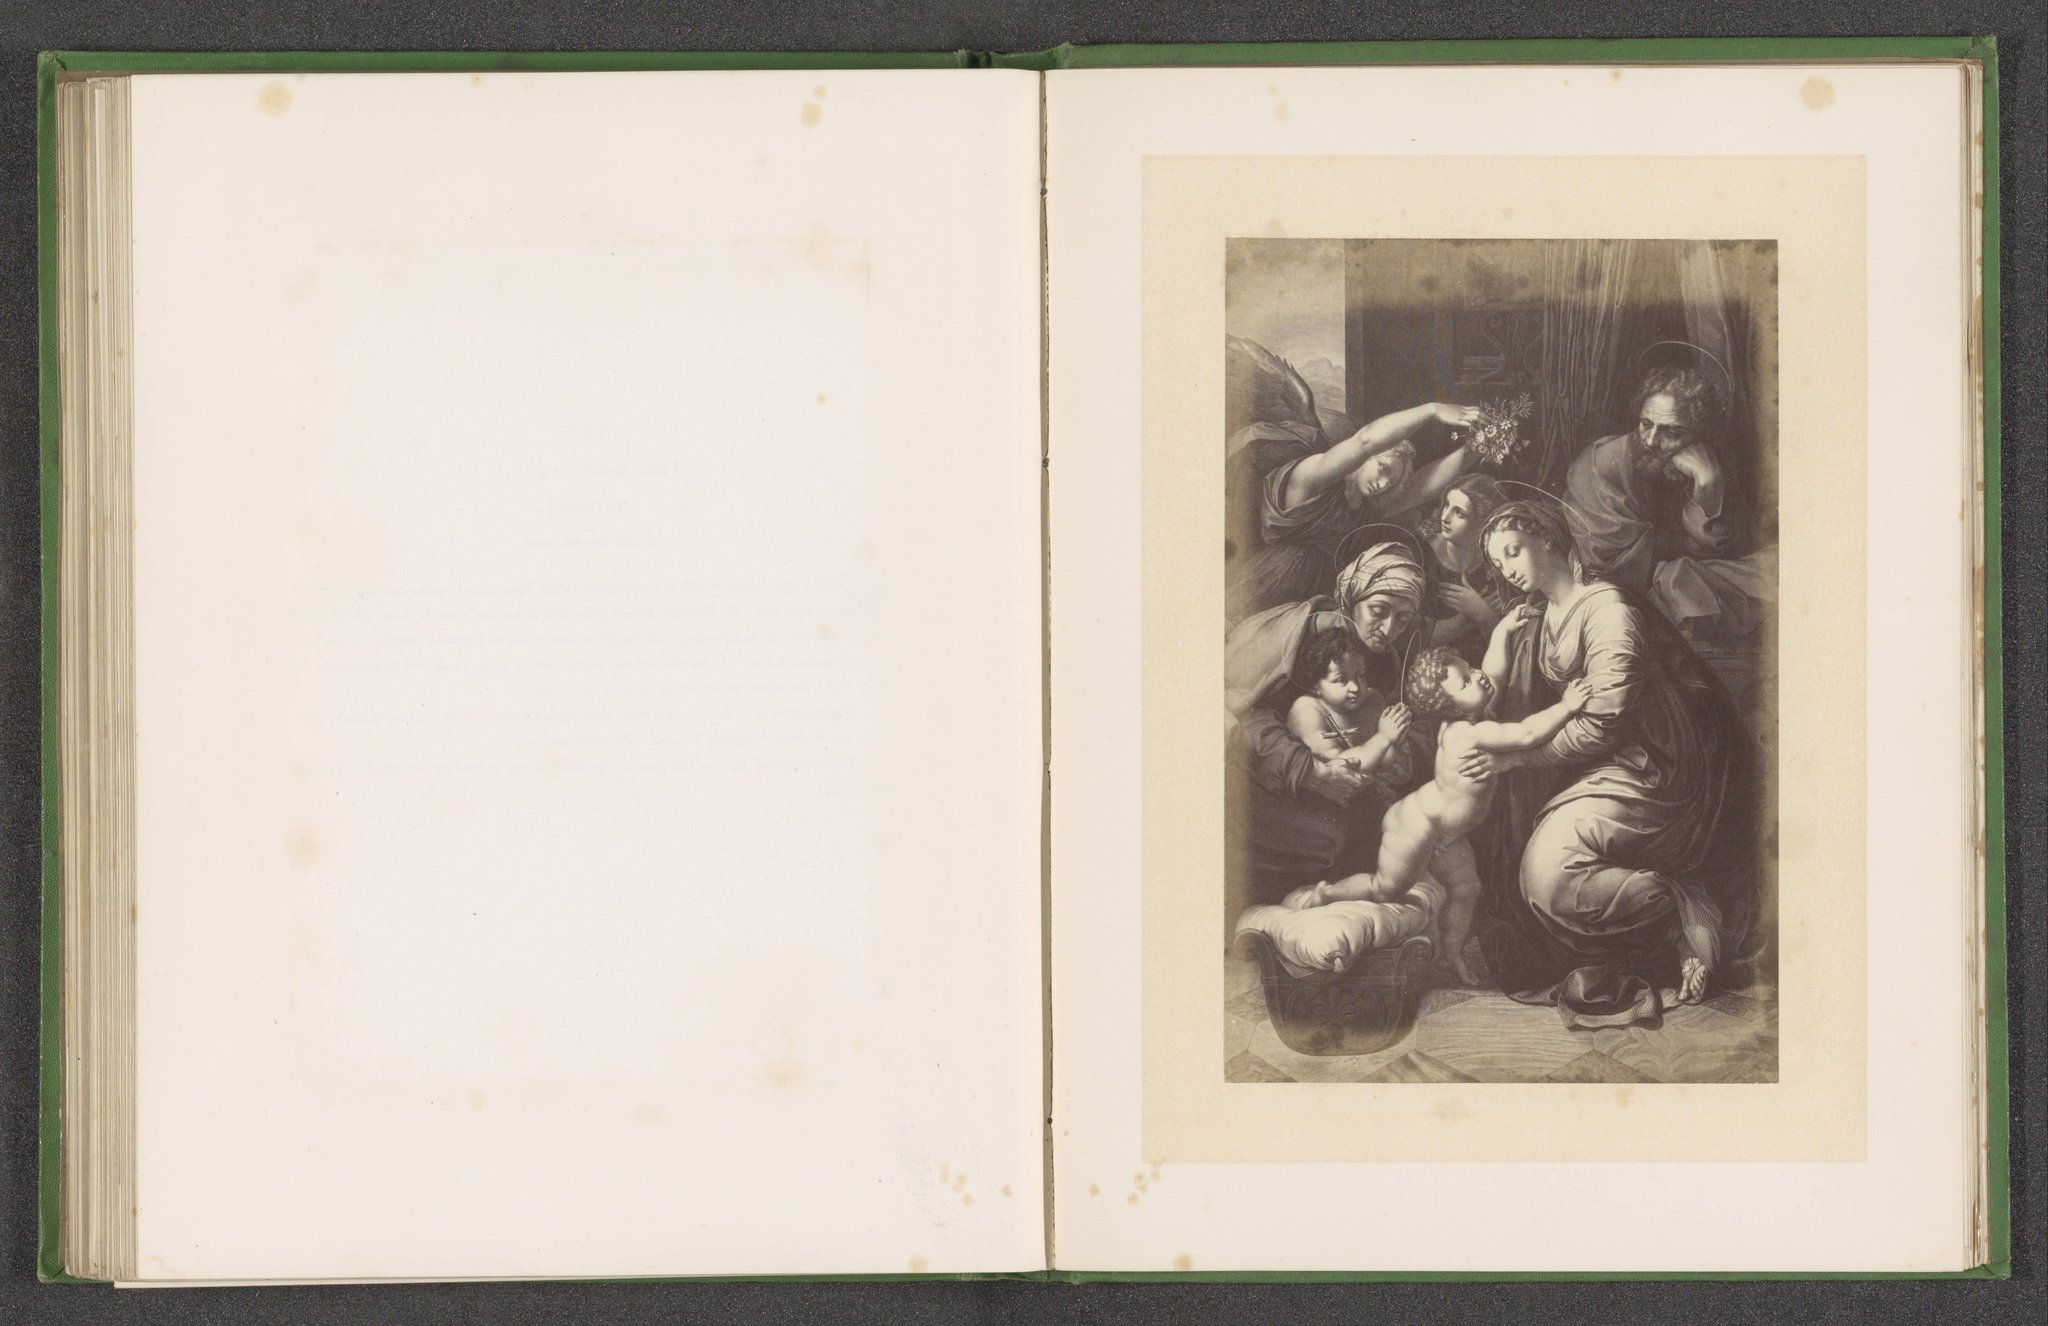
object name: reproduction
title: Fotoreproductie van een prent door Richomme van de Sacra Famiglia di Francesco I door Rafaël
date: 1859-1869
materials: photographic support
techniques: albumen print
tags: holy family, and derived representations